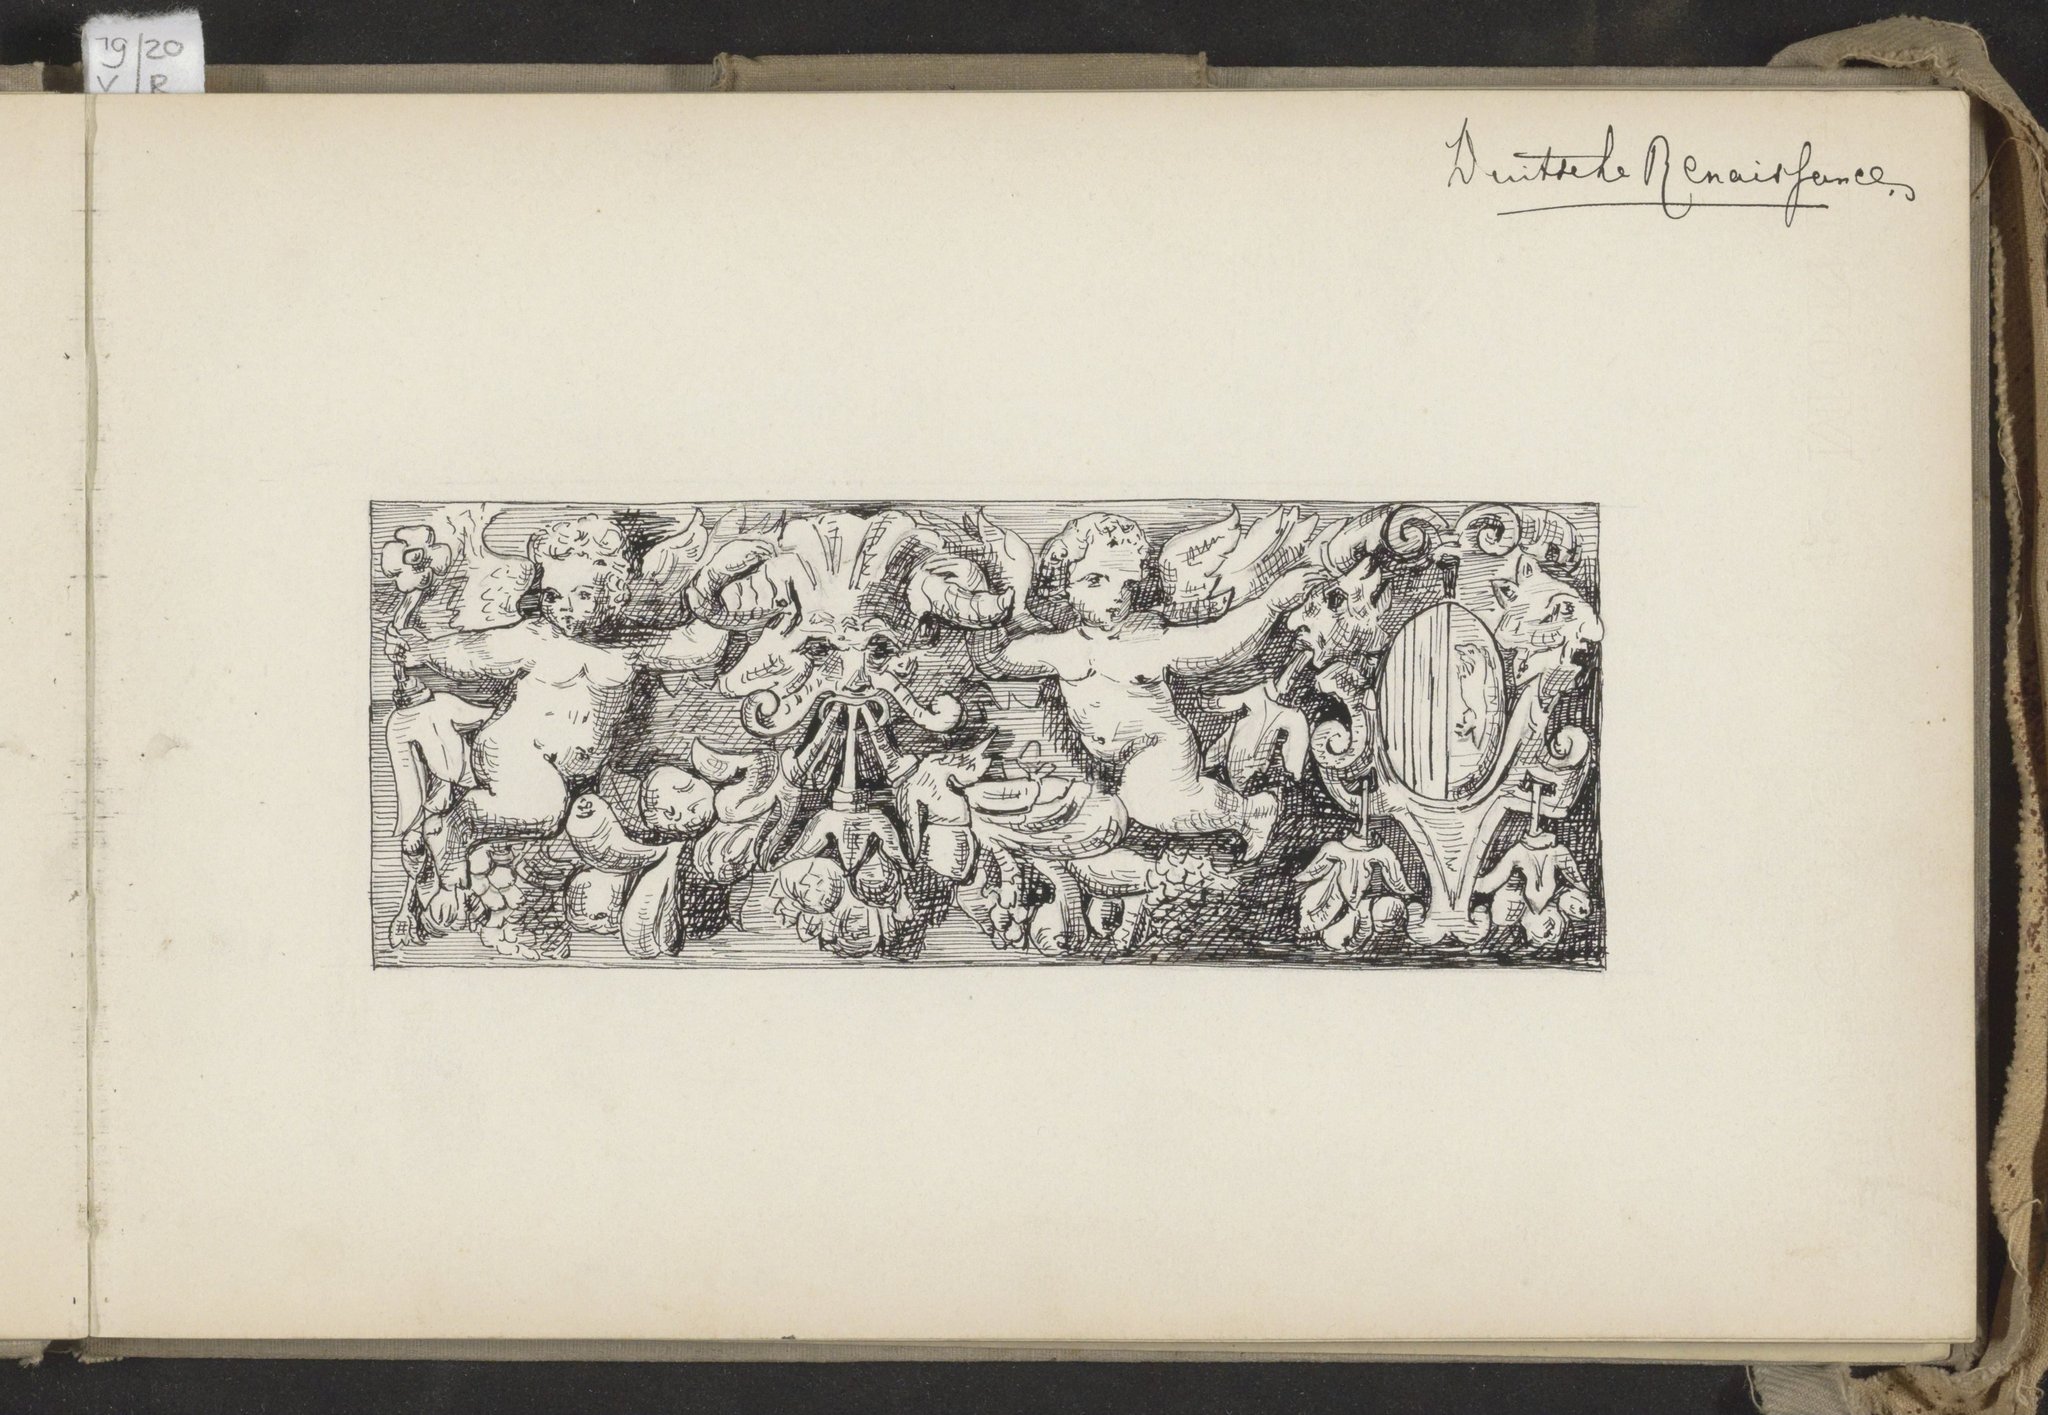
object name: sketchbook leaf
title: Duits renaissancistisch ornament met engelen en cartouche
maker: johanna van de kamer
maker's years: 1873-1922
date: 1890-1922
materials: ink, paper, pencil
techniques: pen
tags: ornaments ~ art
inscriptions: annotation: ‘Duitsche Renaissance.’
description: Blad 15 recto uit een schetsboek met 49 bladen.